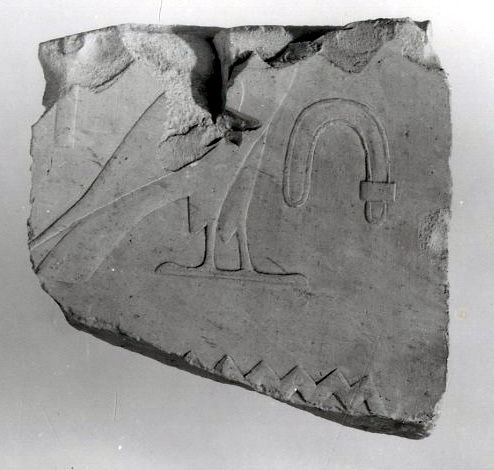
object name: relief fragment, tomb of meketre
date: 1981-1975 BCE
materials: limestone, paint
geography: egypt